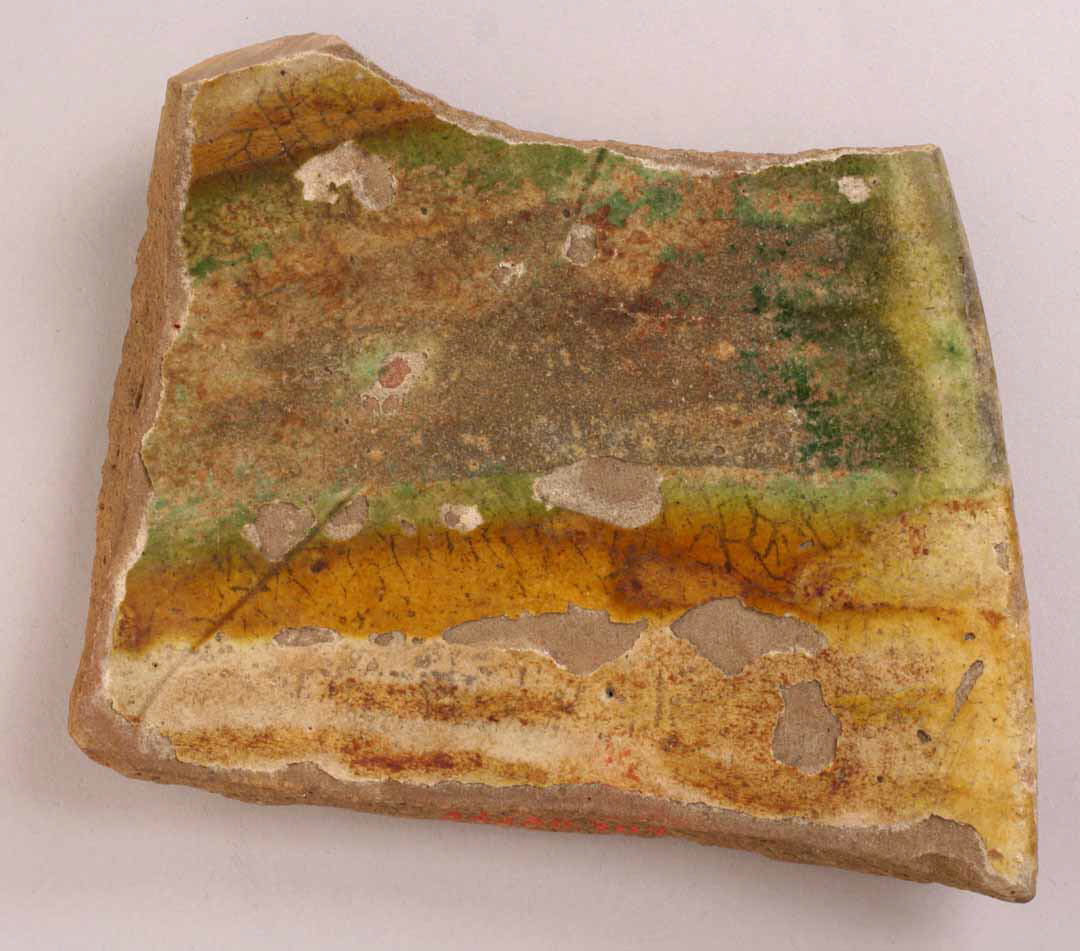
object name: fragment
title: Ceramic Fragment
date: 701-900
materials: earthenware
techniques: glazing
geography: iraq